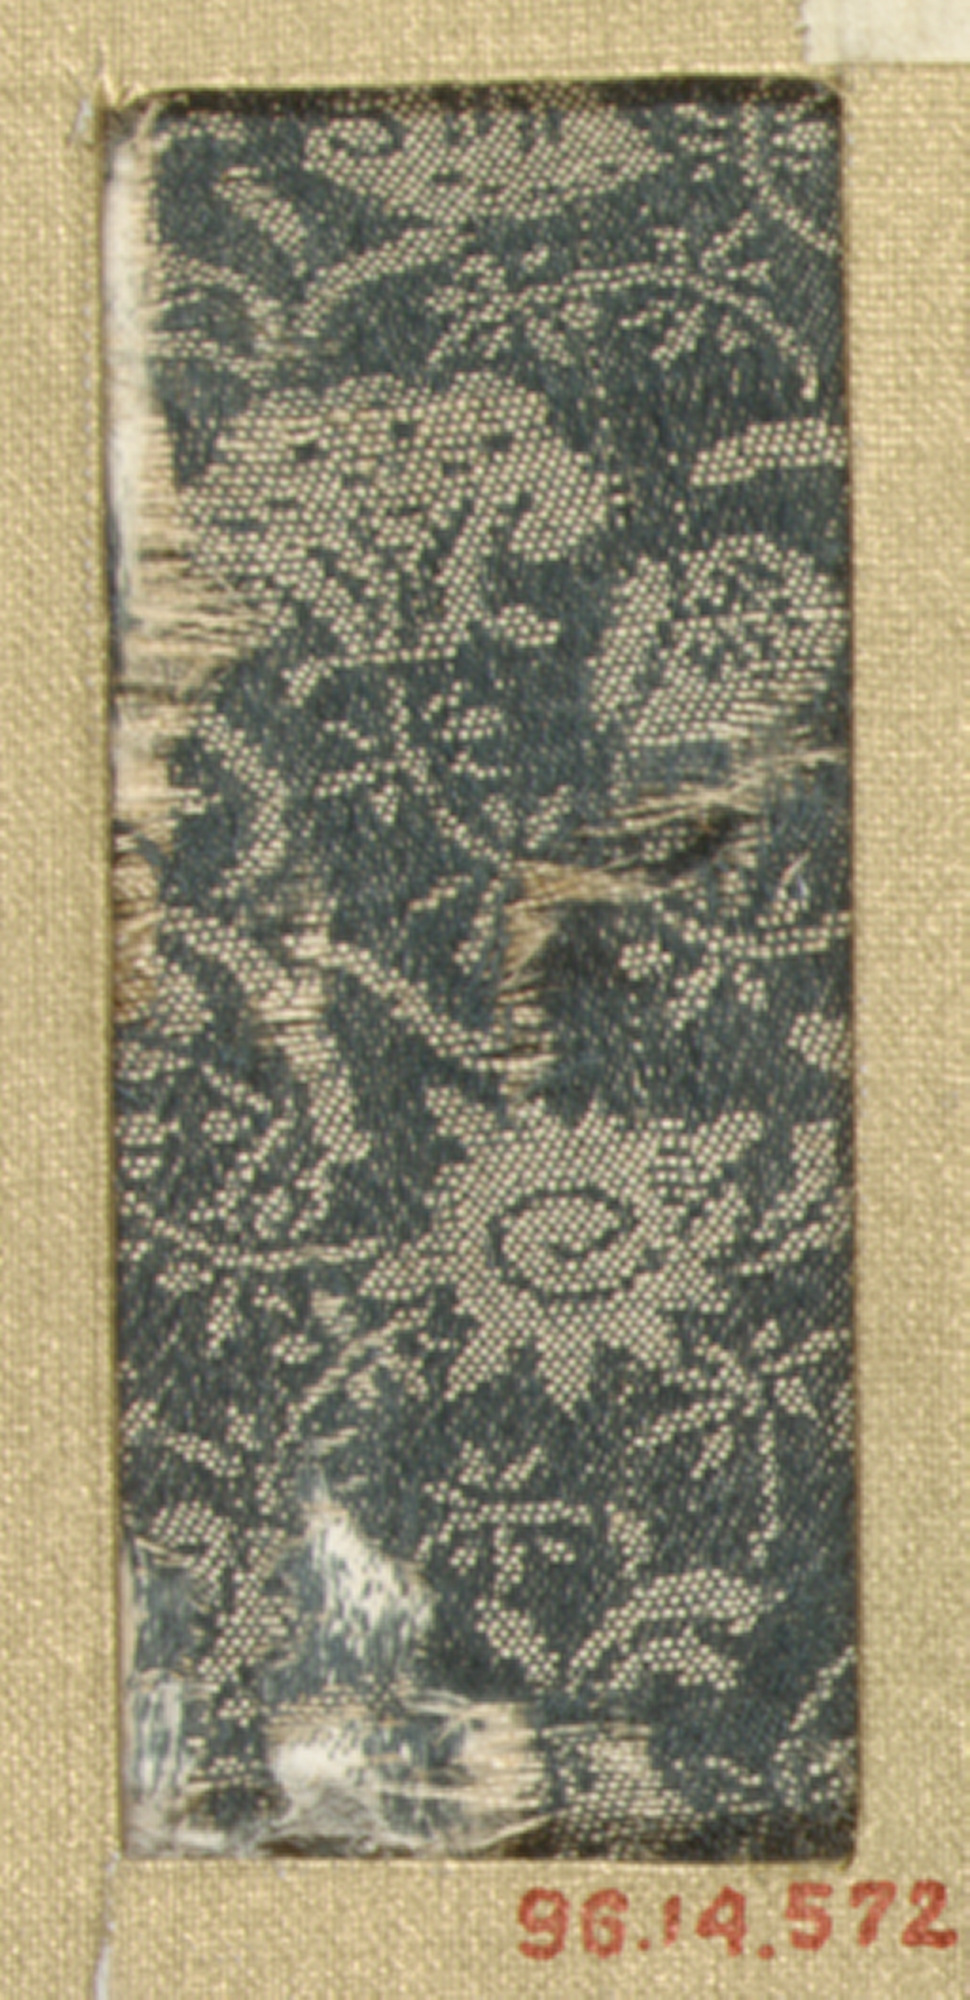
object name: piece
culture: japanese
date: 1701-1900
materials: silk